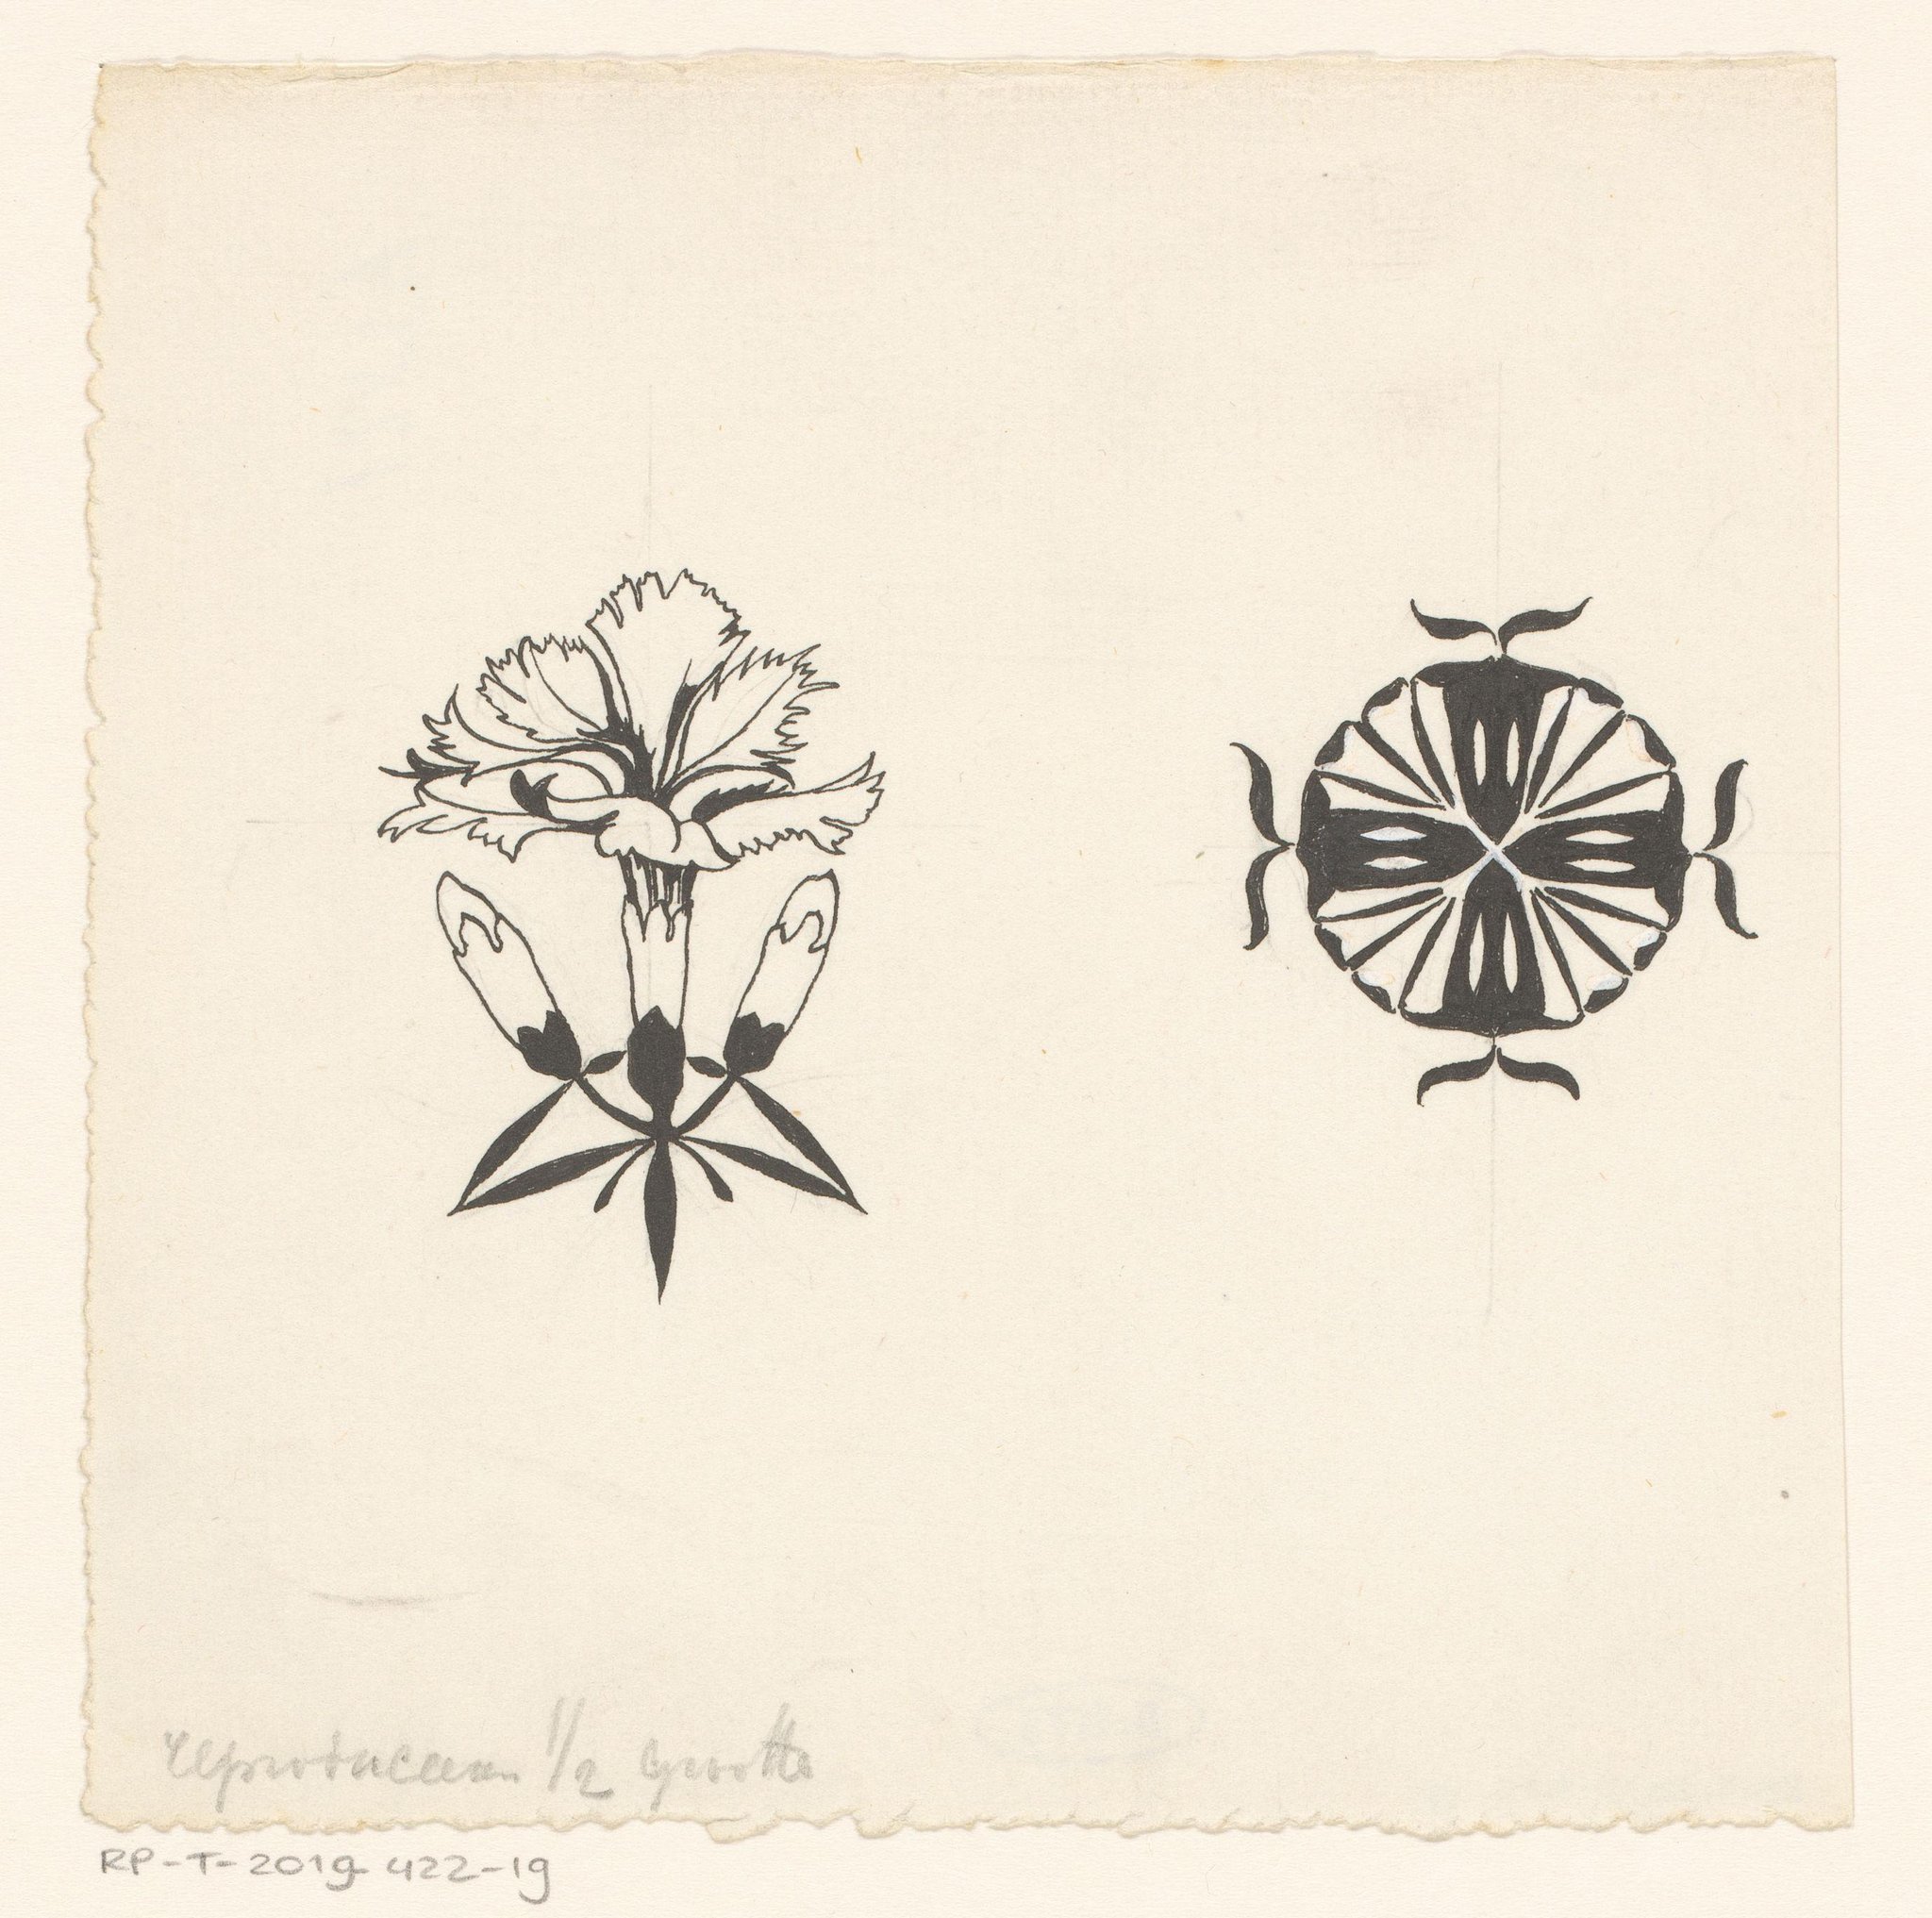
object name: boekillustratie ontwerp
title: Bloem met knoppen en een gestileerd bloemornament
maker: willem wenckebach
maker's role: designer, draughtsman, painter, print maker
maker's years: 1860-1937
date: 1870-1937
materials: paint, ink, paper, pencil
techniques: brush, pen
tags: flowers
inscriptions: :, collector's mark: Lugt 2228